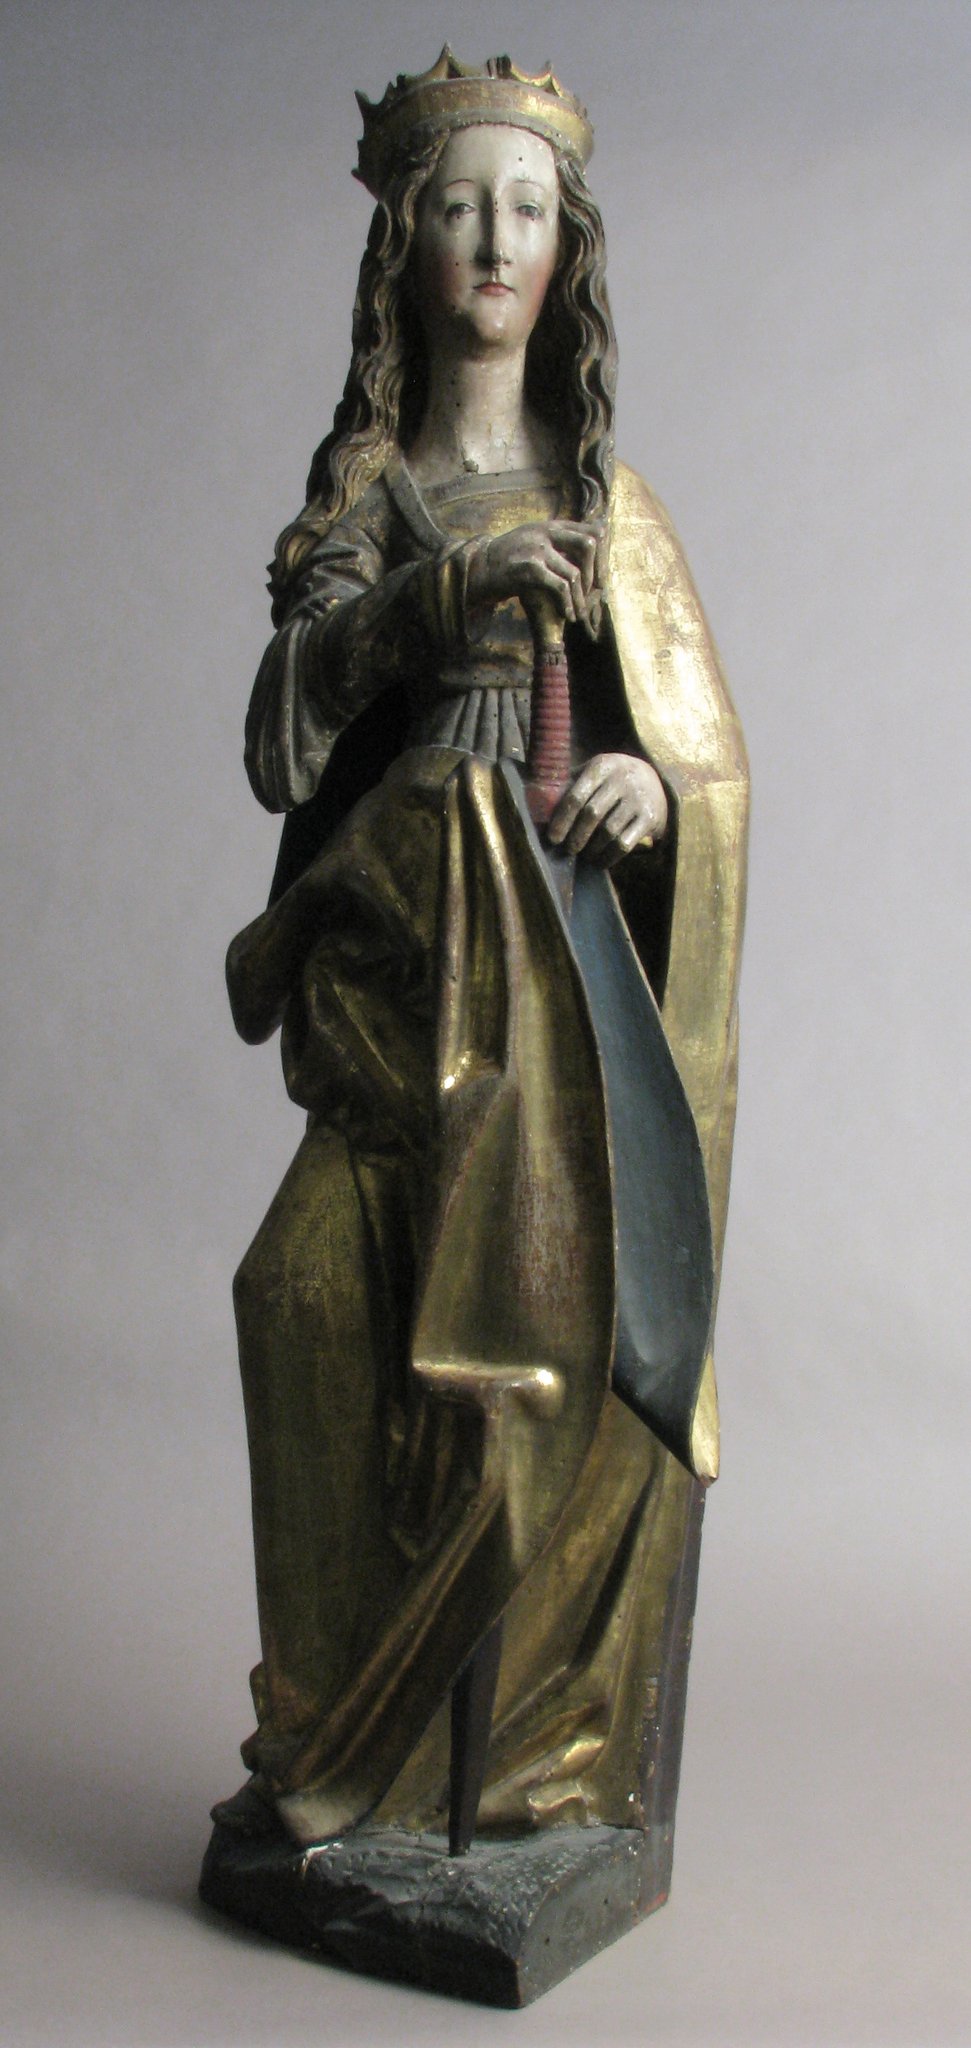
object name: statue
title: Saint Catherine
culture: german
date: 1401-1600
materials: paint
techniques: gilding